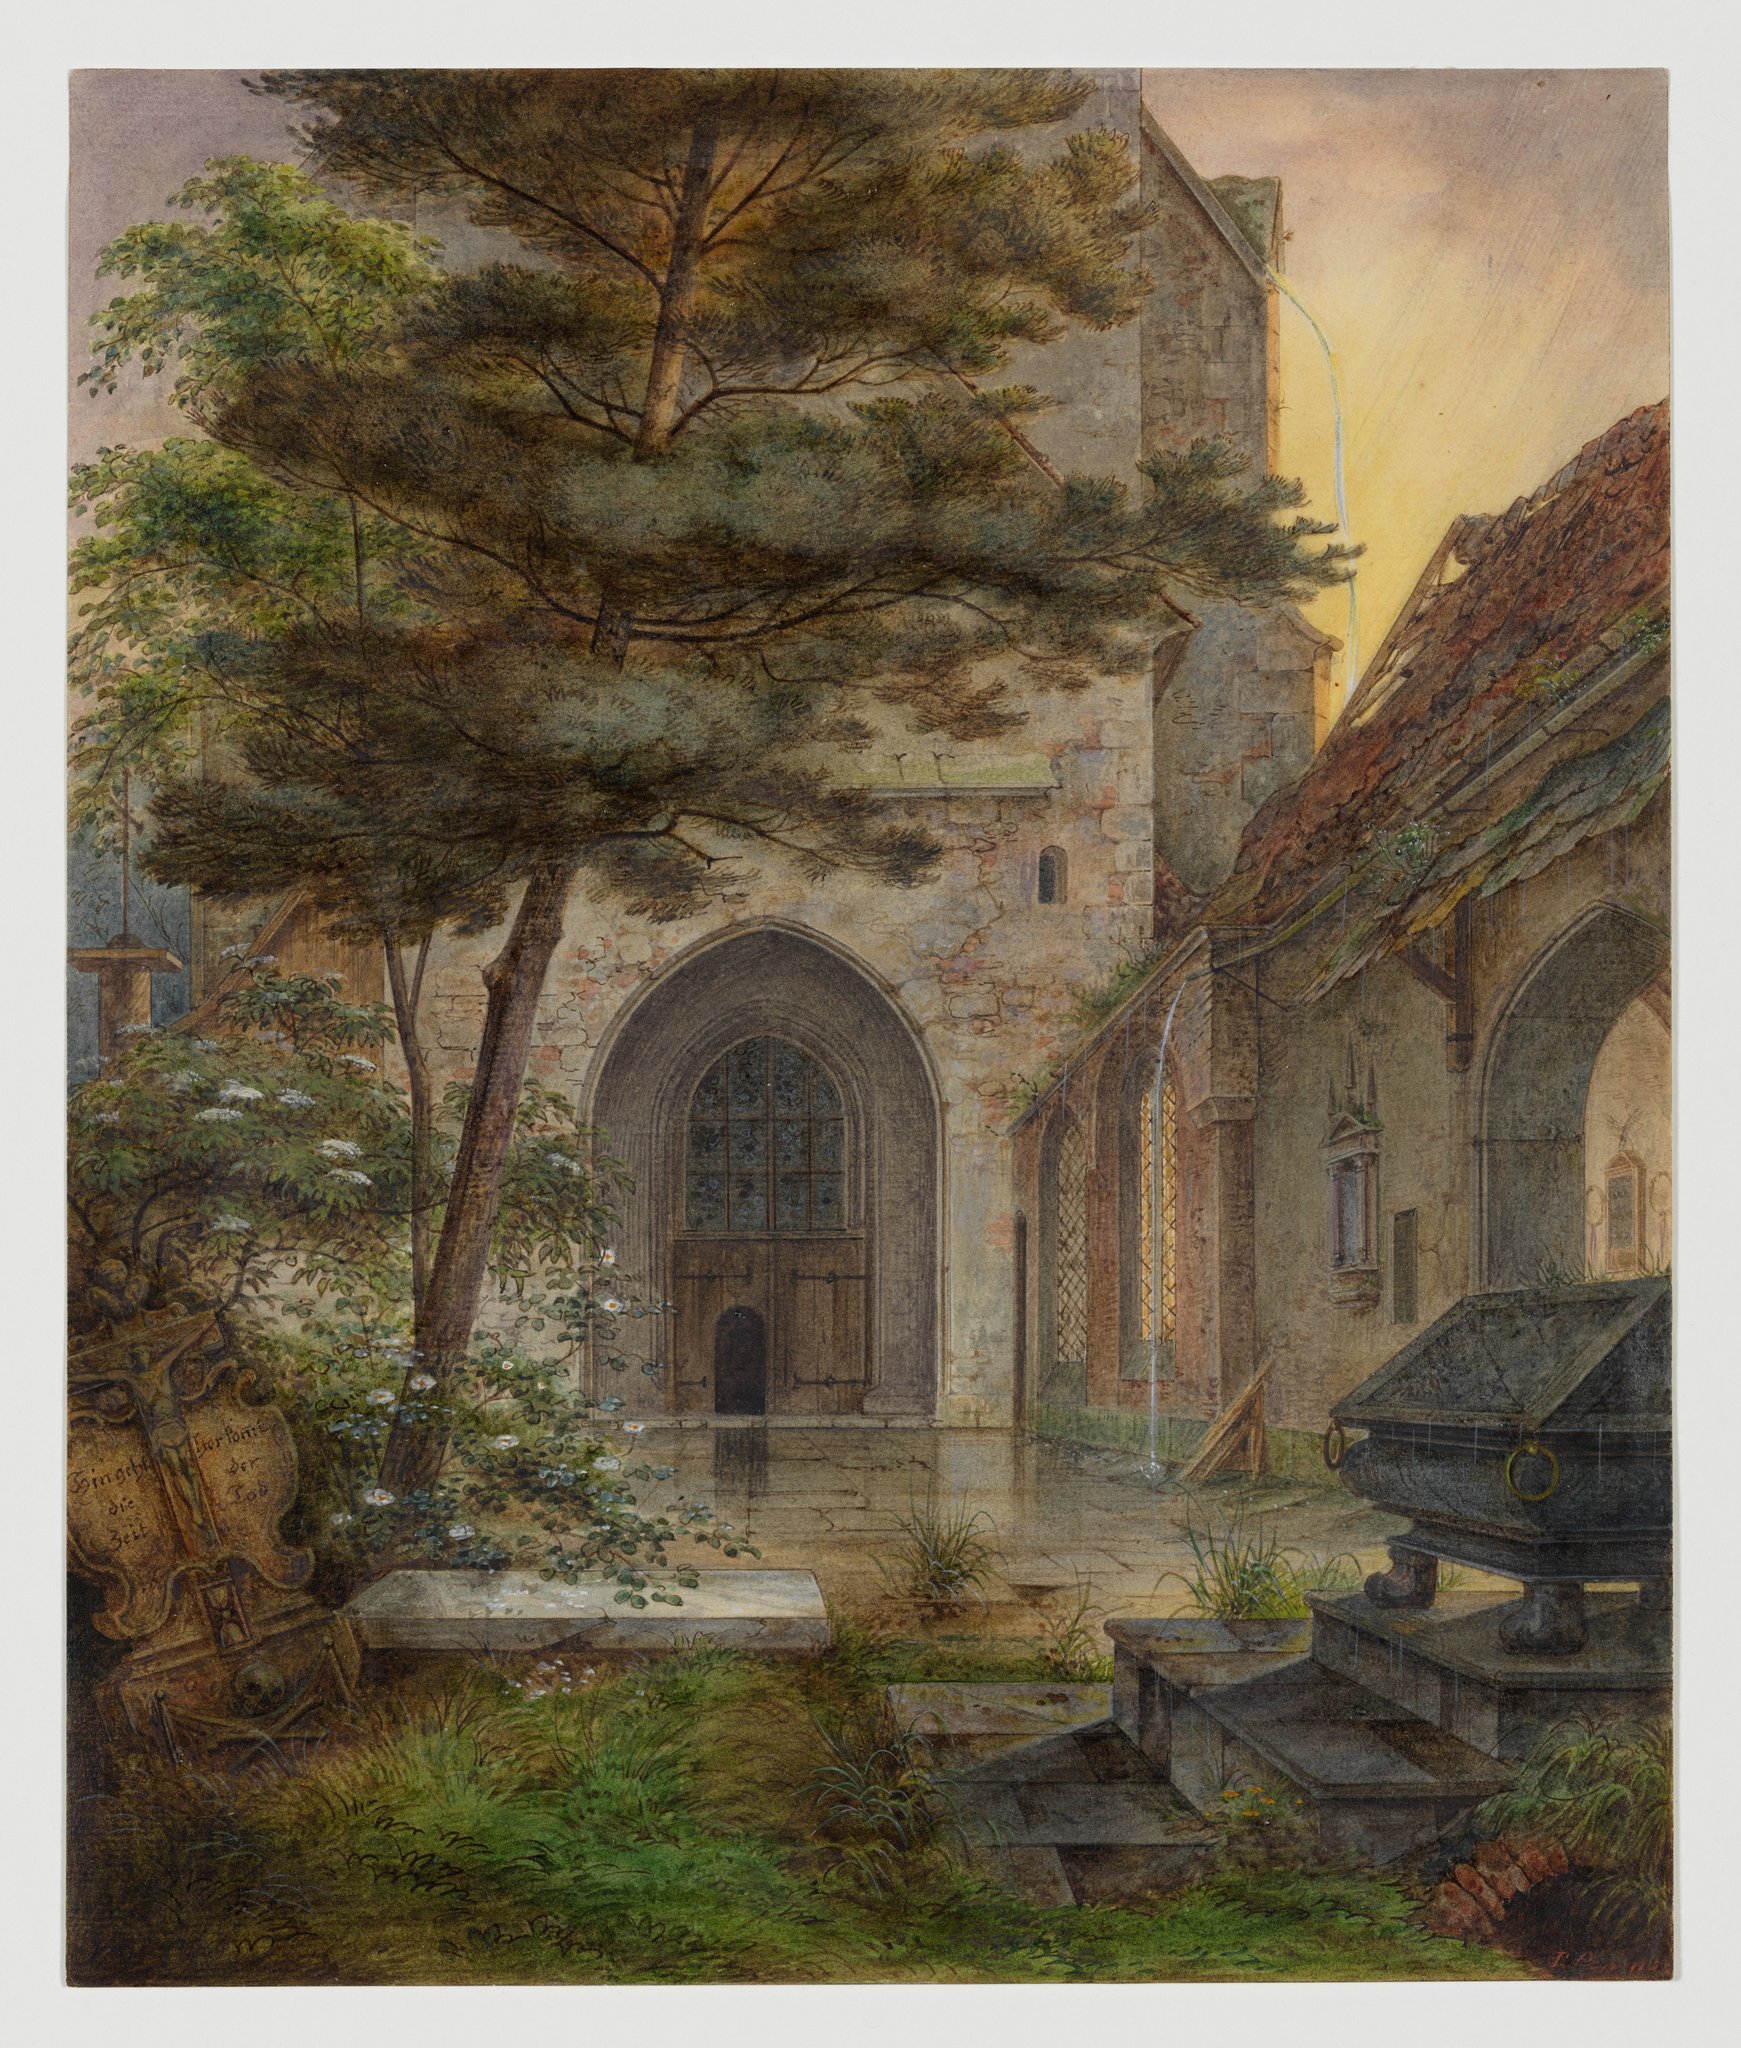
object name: drawing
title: A Portal of a Church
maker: ernst ferdinand oehme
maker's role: artist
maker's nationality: german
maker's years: 1797-1855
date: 1820-1829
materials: ink, watercolor, paper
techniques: heightening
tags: churches